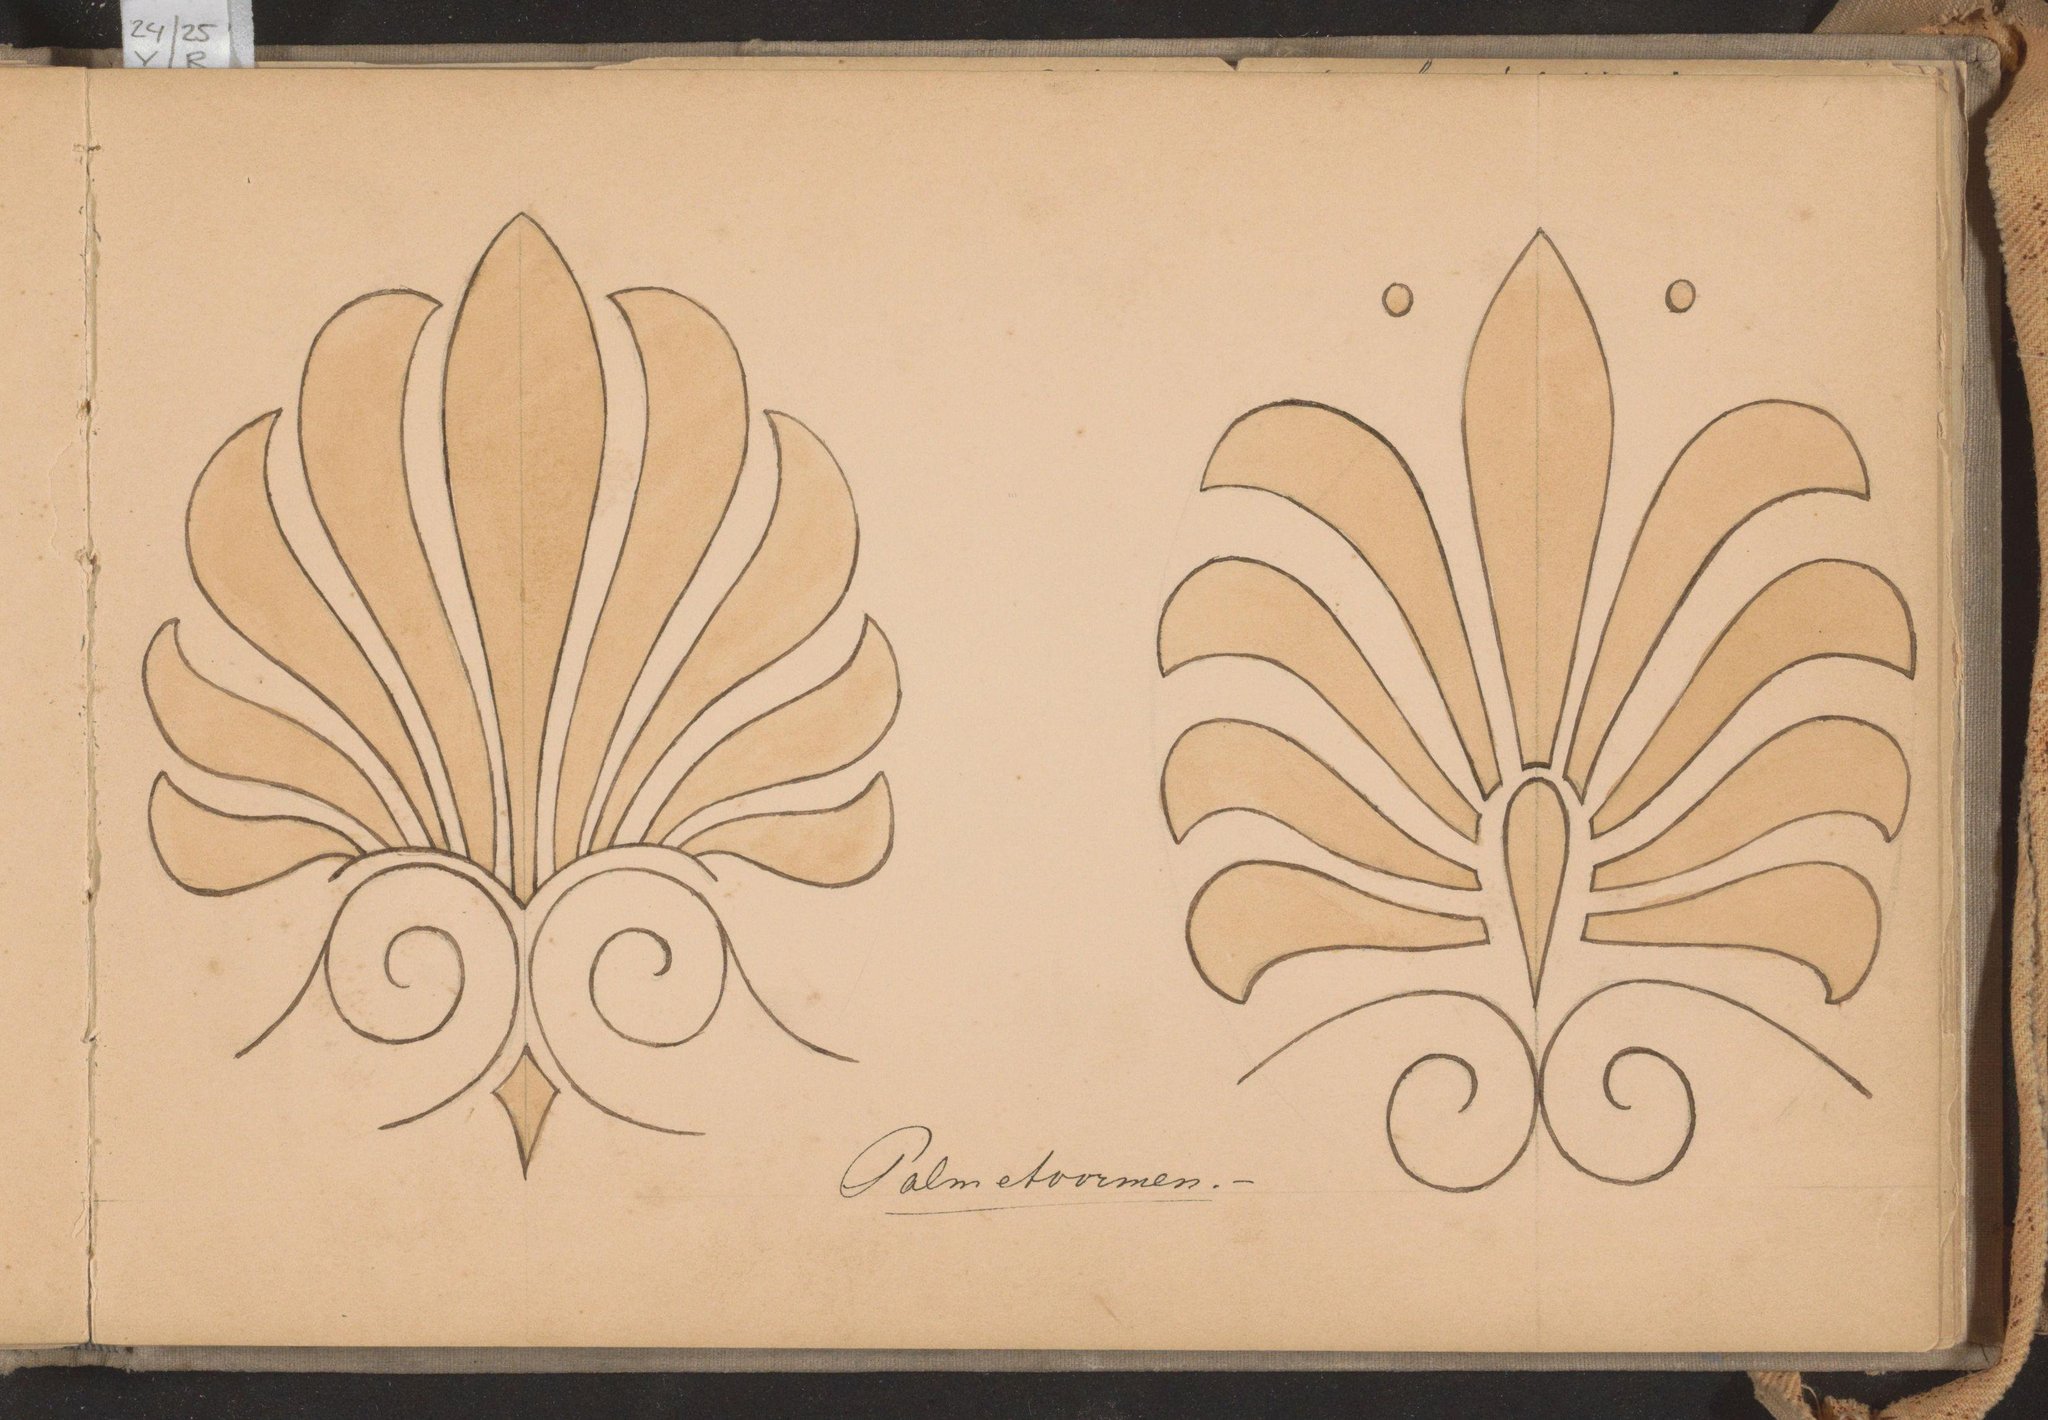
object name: sketchbook leaf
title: Palmetvormen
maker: johanna van de kamer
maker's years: 1873-1922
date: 1890-1922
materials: ink, paper, pencil, watercolor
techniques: brush, pen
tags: palmette ~ ornament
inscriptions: annotation: ‘Palmetvormen.-’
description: Blad 20 recto uit een schetsboek met 43 bladen.